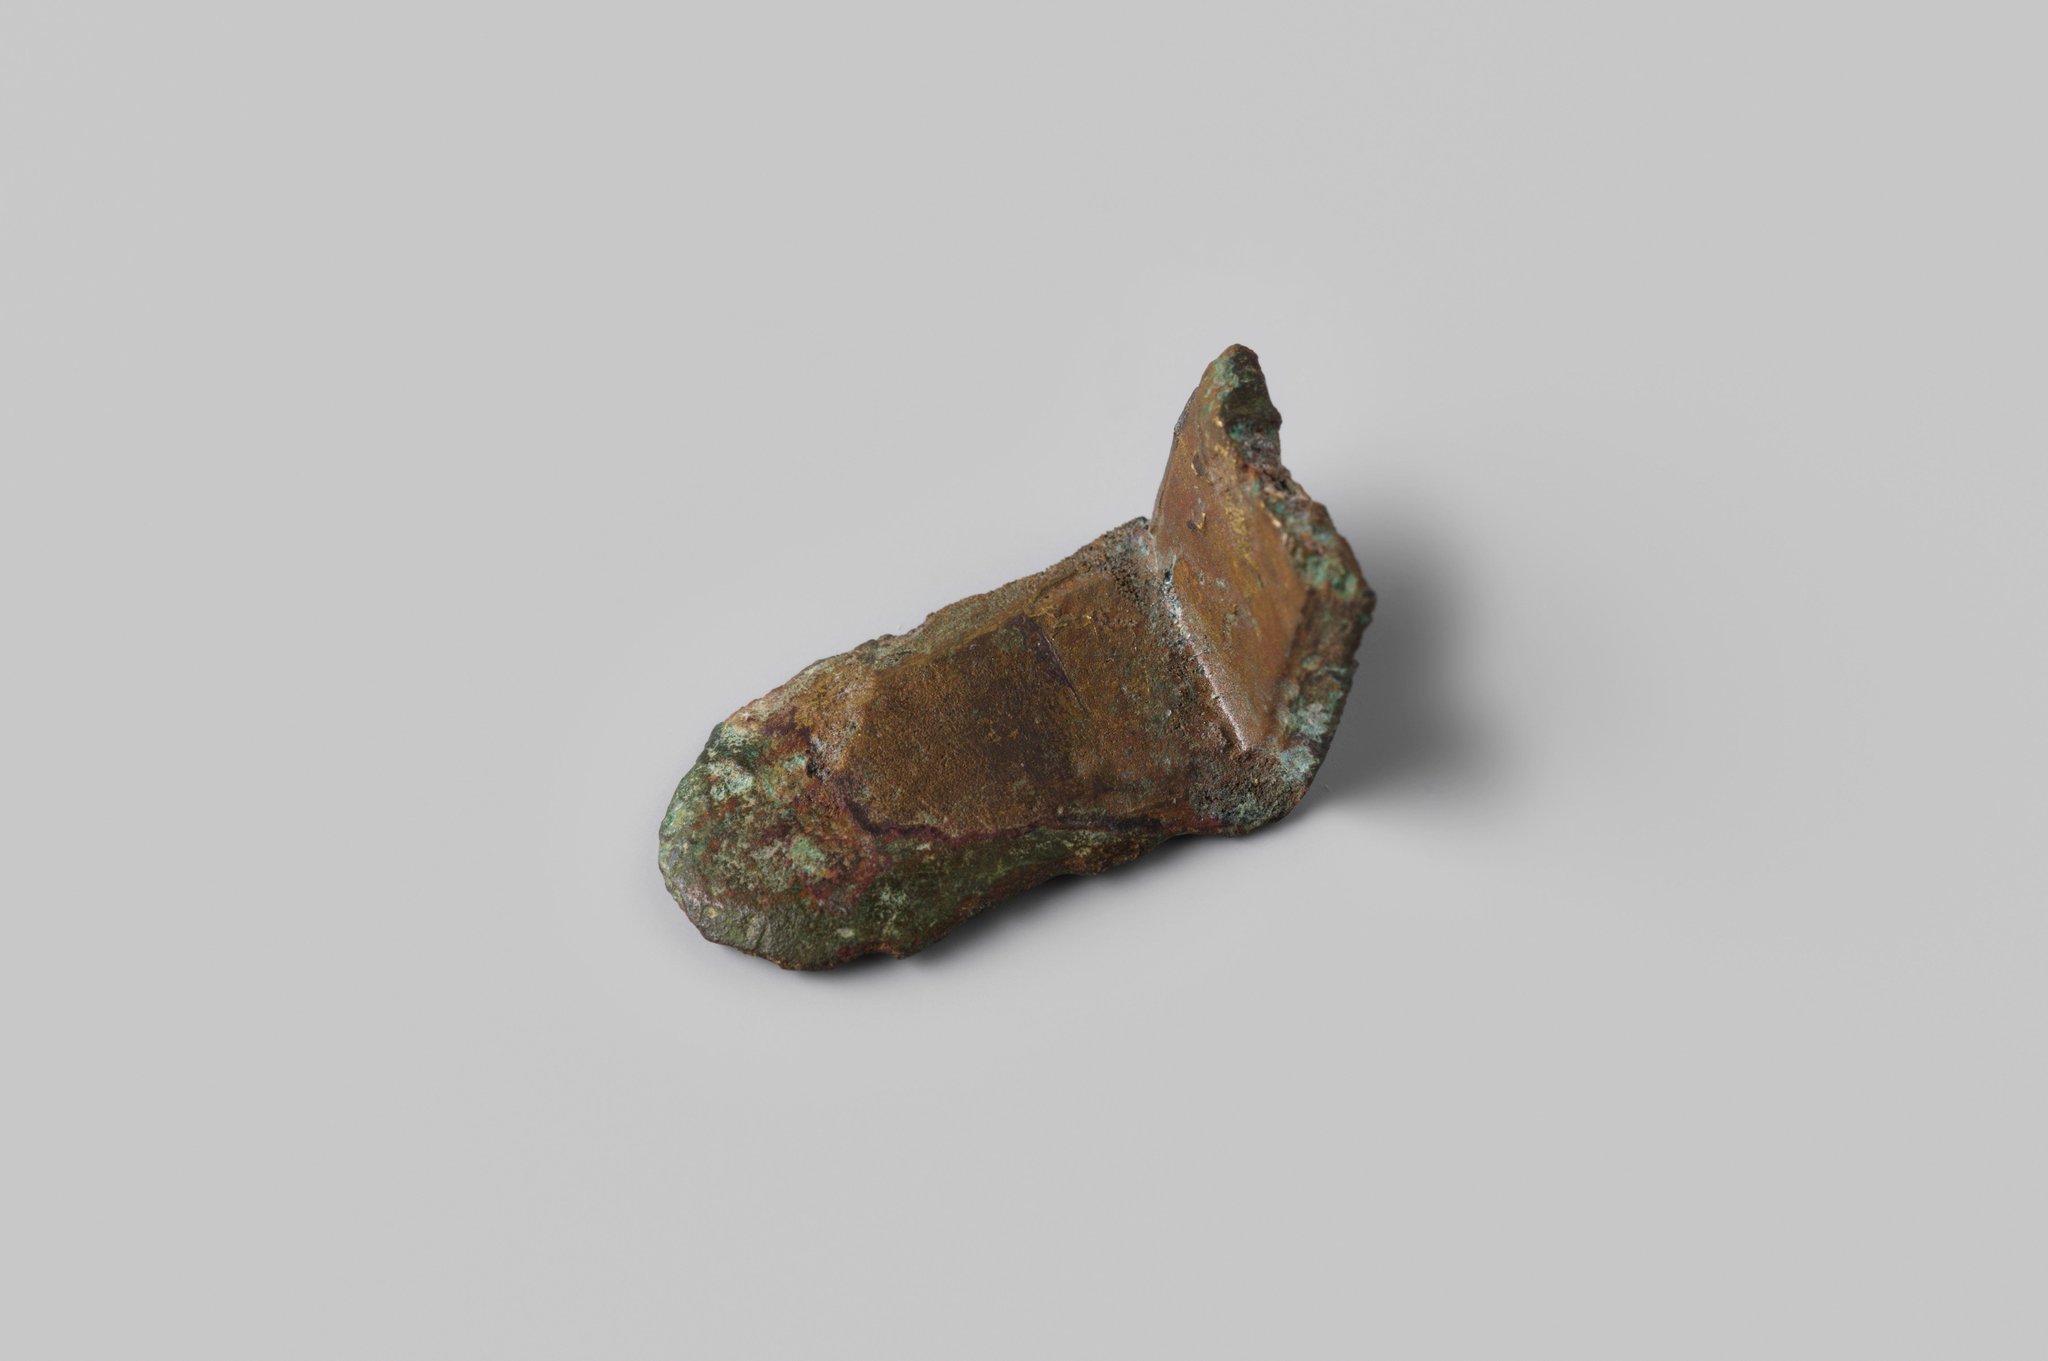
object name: fragment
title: Fragment van koper uit het wrak van de Oost-Indiëvaarder Hollandia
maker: Anonymous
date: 1700-1743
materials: copper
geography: netherlands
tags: verenigde oostindische compagnie, hollandia (schip), annet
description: Varied parts or fragments, strips and strip-shaped fragments; fragm.